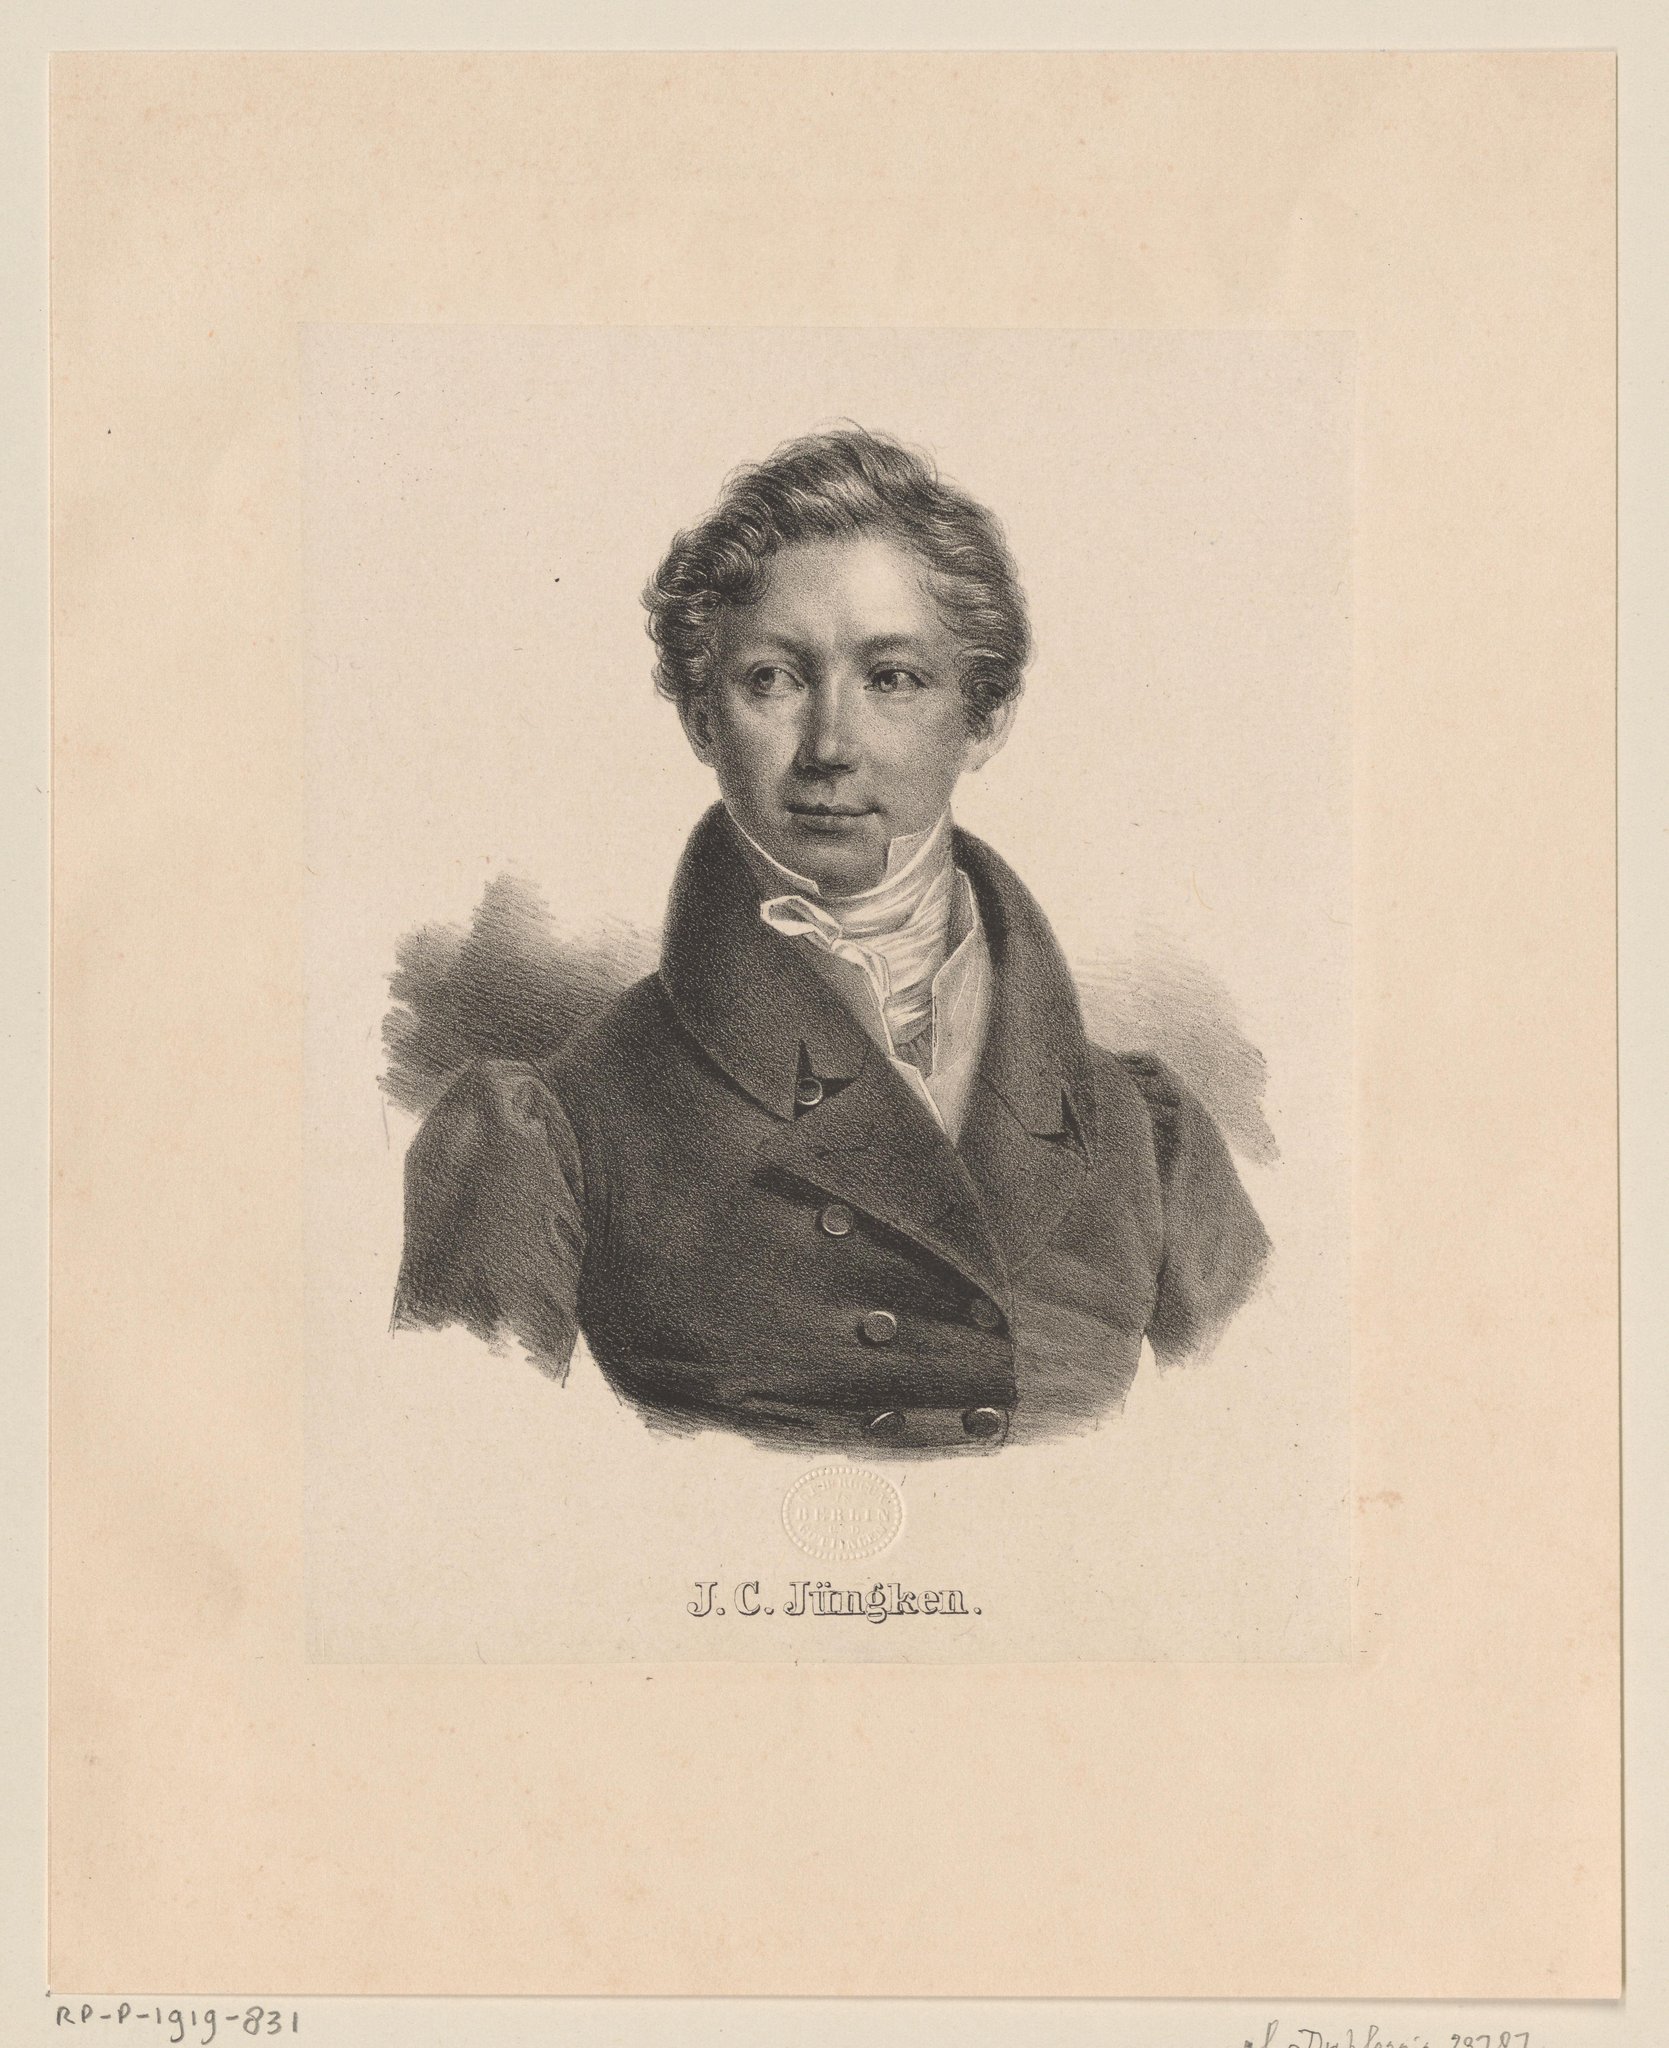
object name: print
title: Portret van Johann Christian Jüngken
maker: Anonymous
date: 1830-1863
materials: paper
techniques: lithograph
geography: berlin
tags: historical persons, barber; surgeon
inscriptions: check stamp: 5514, collector's mark: Lugt 2228